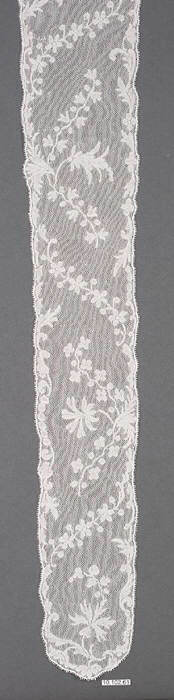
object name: barbe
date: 1701-1800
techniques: lace